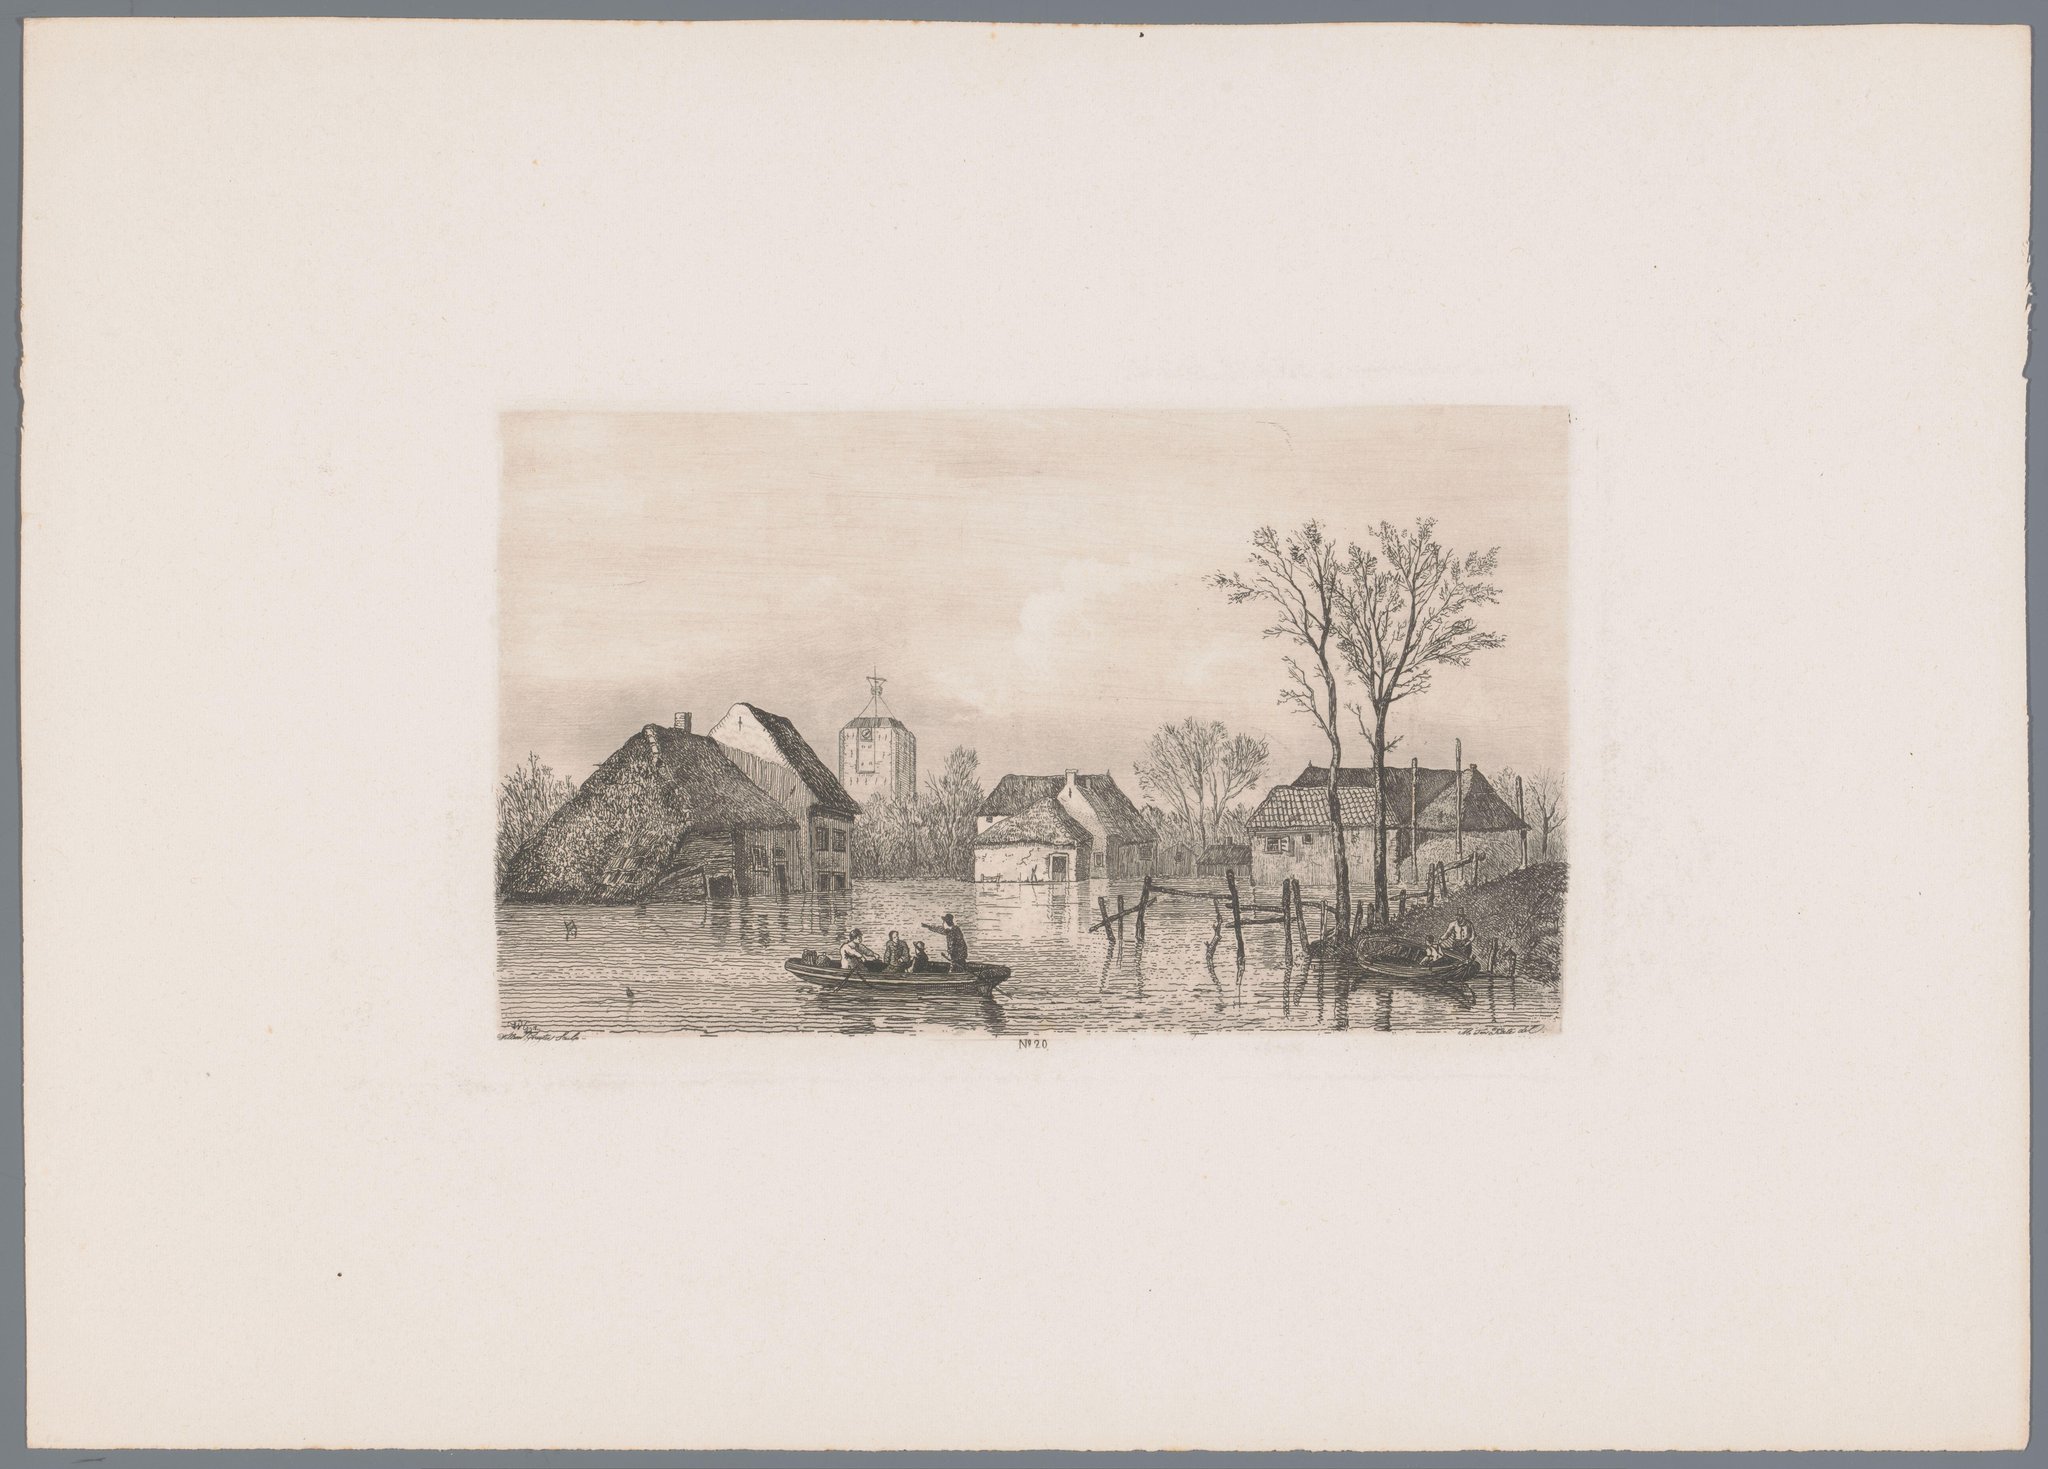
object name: print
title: Watersnood te Beesd, 1855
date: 1855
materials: paper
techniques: etching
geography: netherlands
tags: flood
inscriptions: collector's mark: Lugt 2228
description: Het onder water staande dorp Beesd aan de Linge, 10 maart 1855. Onderdeel van de reeks van 24 prenten over de watersnood van maart 1855, door leden van het genootschap Arti et Amicitiae. Uitgave ten behoeve van de slachtoffers van de watersnood.